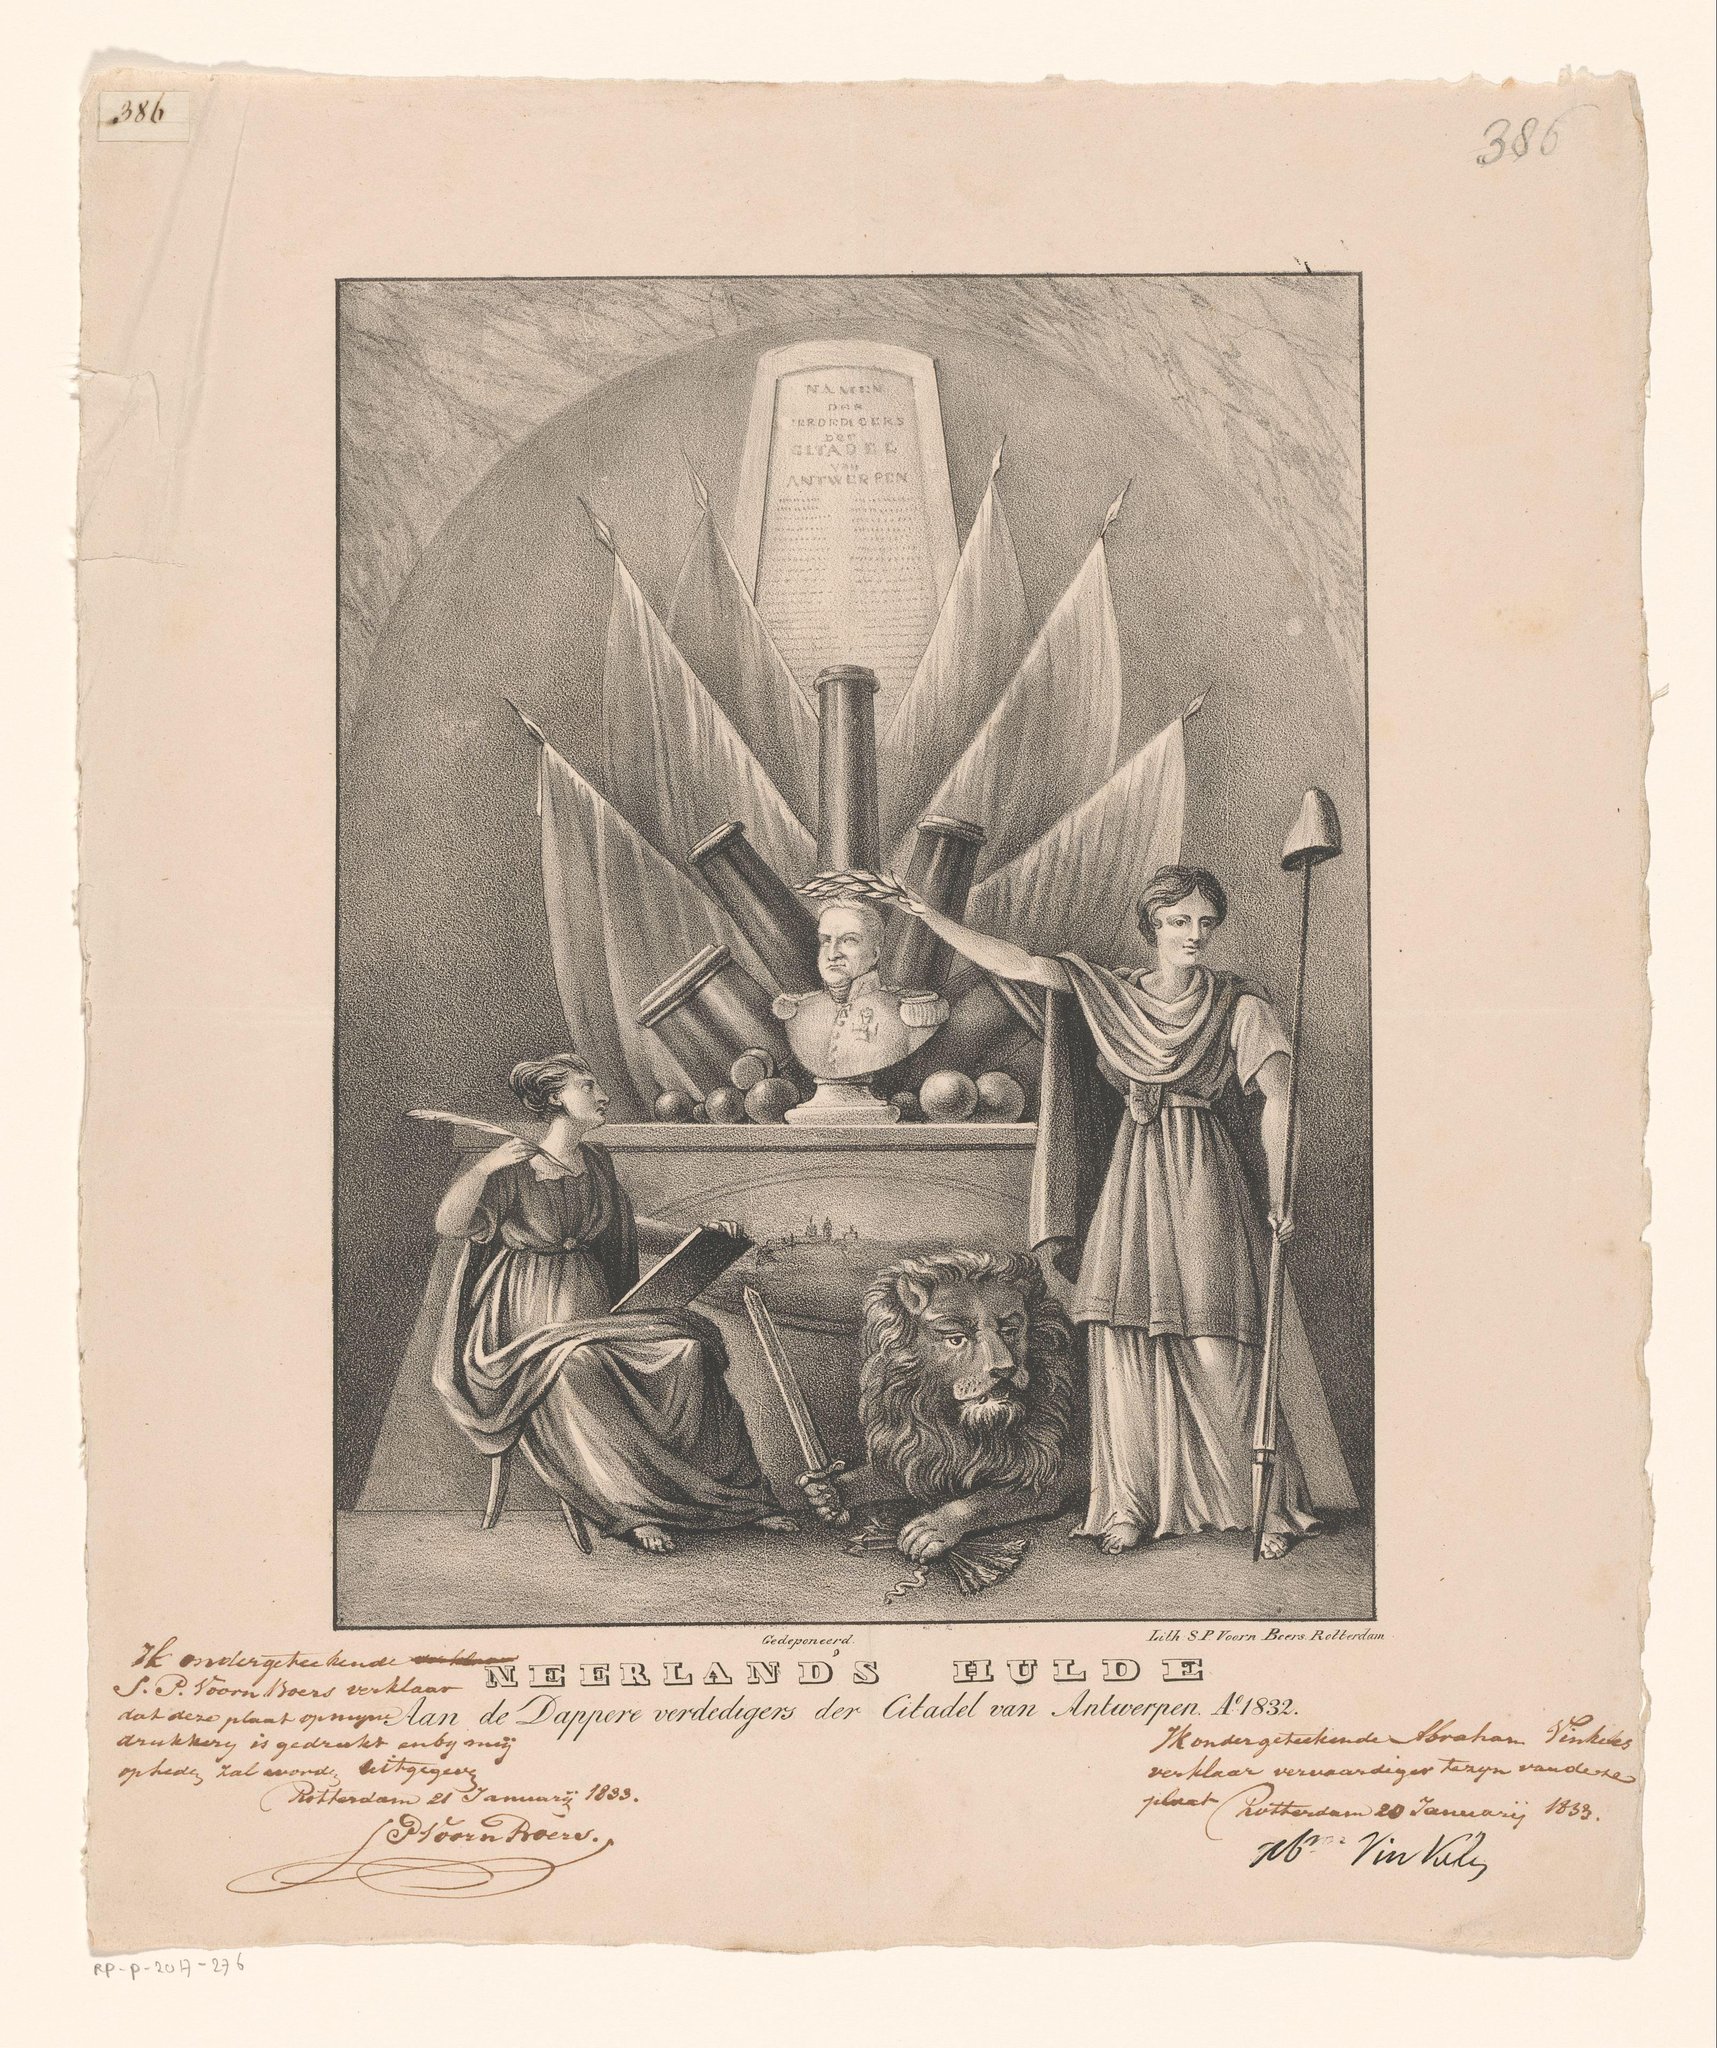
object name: print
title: Nederland's hulde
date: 1833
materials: paper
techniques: lithograph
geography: rotterdam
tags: david hendrik baron chassé, monument, statue, freedom, liberty; 'libertà' (ripa), beasts of prey, predatory animals: lion, antwerp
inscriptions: : ‘Gedeponeerd.’, : ‘Ik ondergetekende Abraham Vinkeles / verklaar vervaardiger te zijn van deze / plaat Rotterdam 20 januari 1833 / Am. Vinkeles’, : ‘Ik ondergeteekende / S.P. Voorn Boers verklaar / dat deze plaat op mijn / drukkerij is gedrukt en bij mij / op heden zal worden uitgegeven / Rotterdam 21 Januari 1833 / SPVoornBoers’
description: Personificatie van de vrijheid, rechts met vrijheidshoed, houdt een lauwerkrans boven de portretbuste van generaal David Hendrik Chassé. Achter de buste kanonnen, kogels, vaandels en de namen van de andere militairen. Op de sokkel een gezicht op Antwerpen, daarvoor een leeuw met zwaard en pijlenbundel. Links vereeuwigd een vrouw de heldendaden van Chassé in schrift.